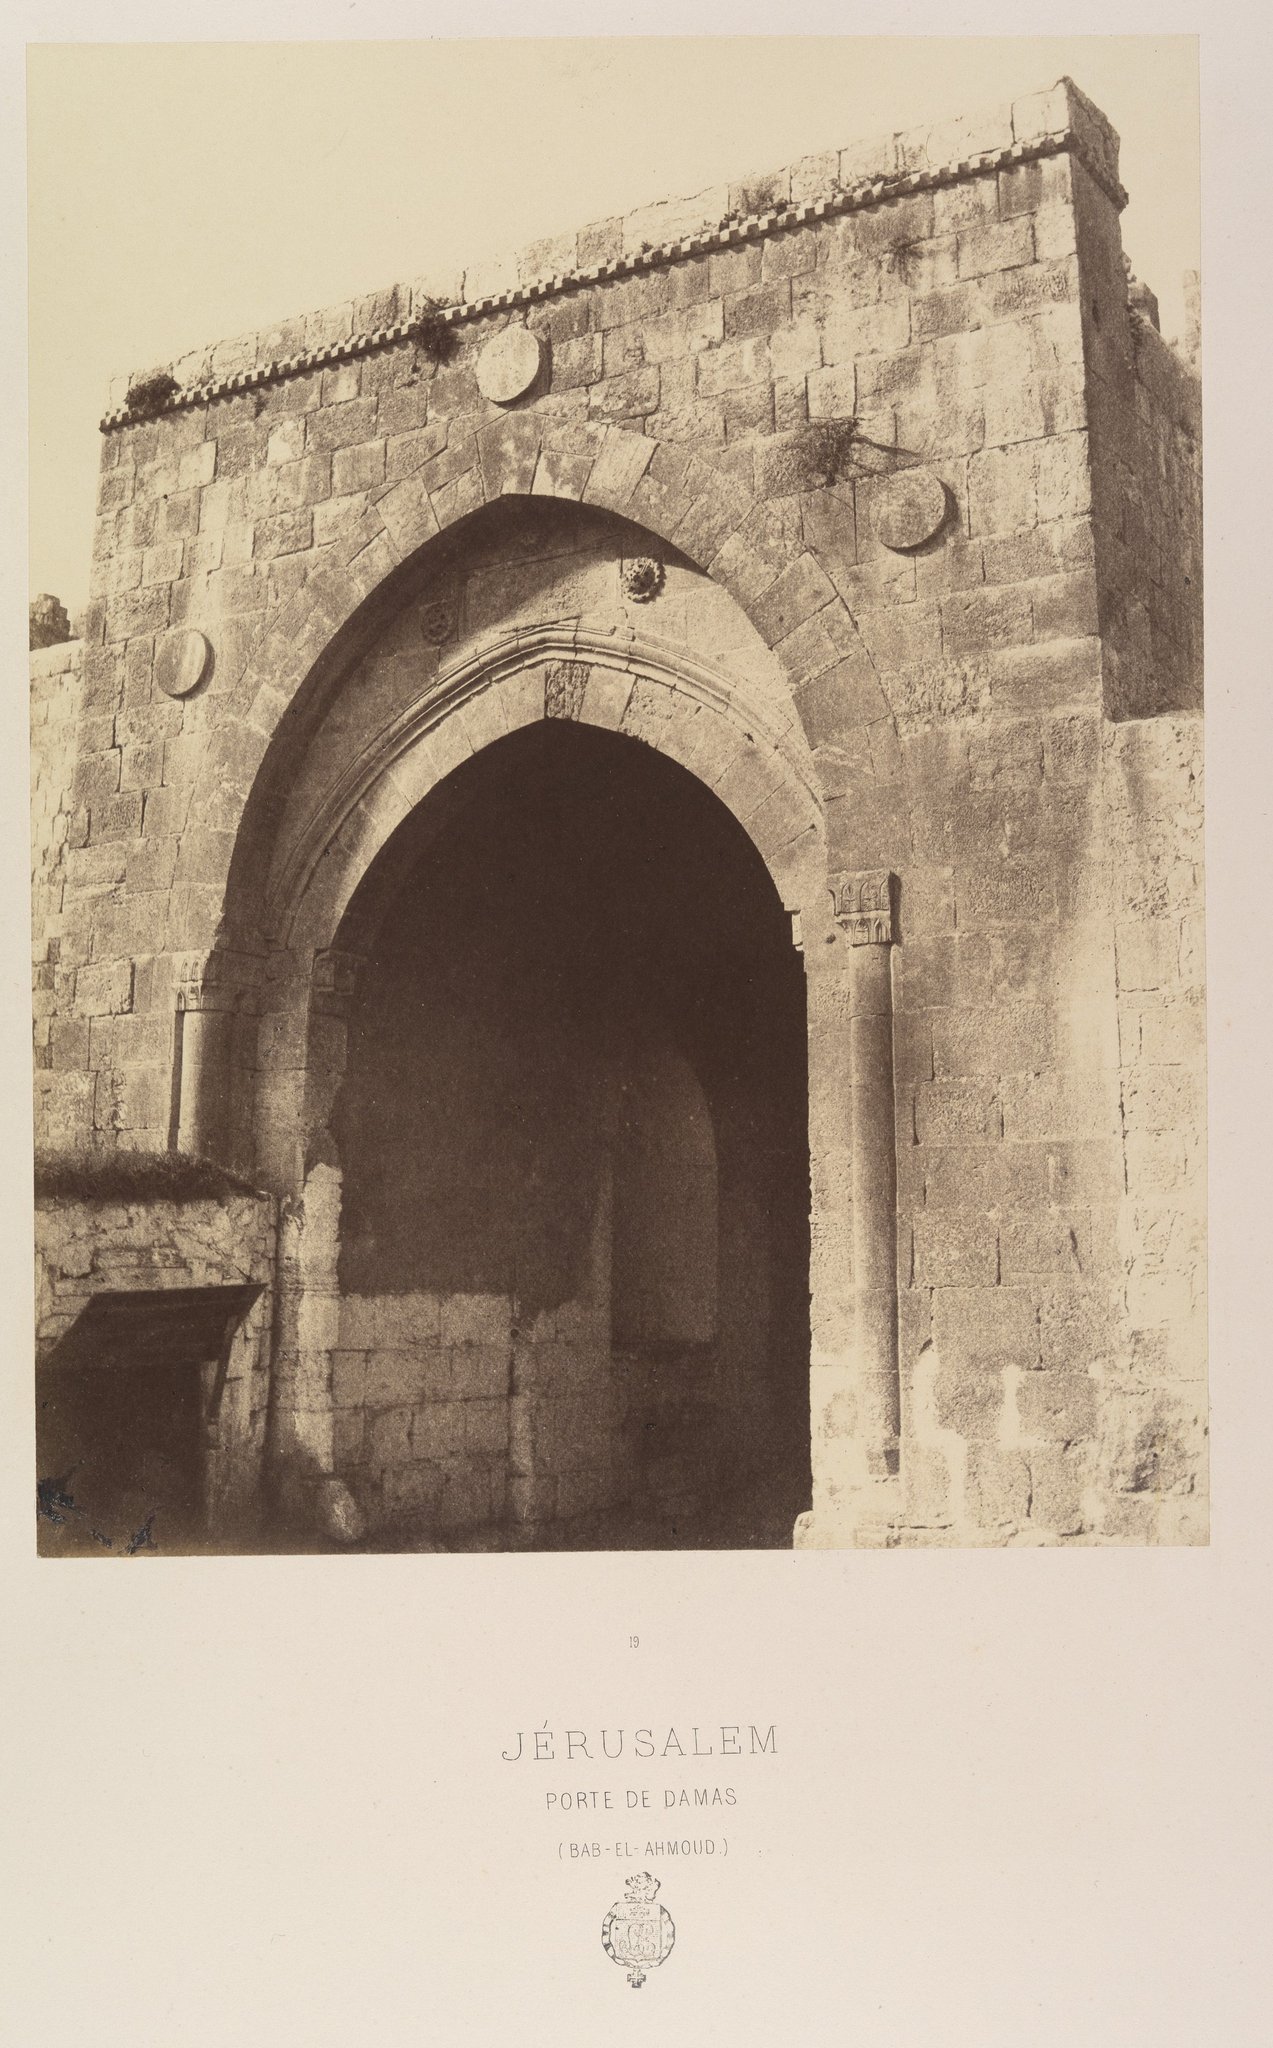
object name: photograph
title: Jérusalem. Porte de Damas (Bab-el-Ahmoud)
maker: louis de clercq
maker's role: artist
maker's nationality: french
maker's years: 1837-1901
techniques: albumen silver print, paper negative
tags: architecture,arches,gates